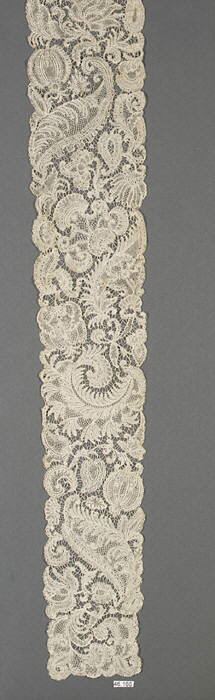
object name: lappet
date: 1700-1750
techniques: lace